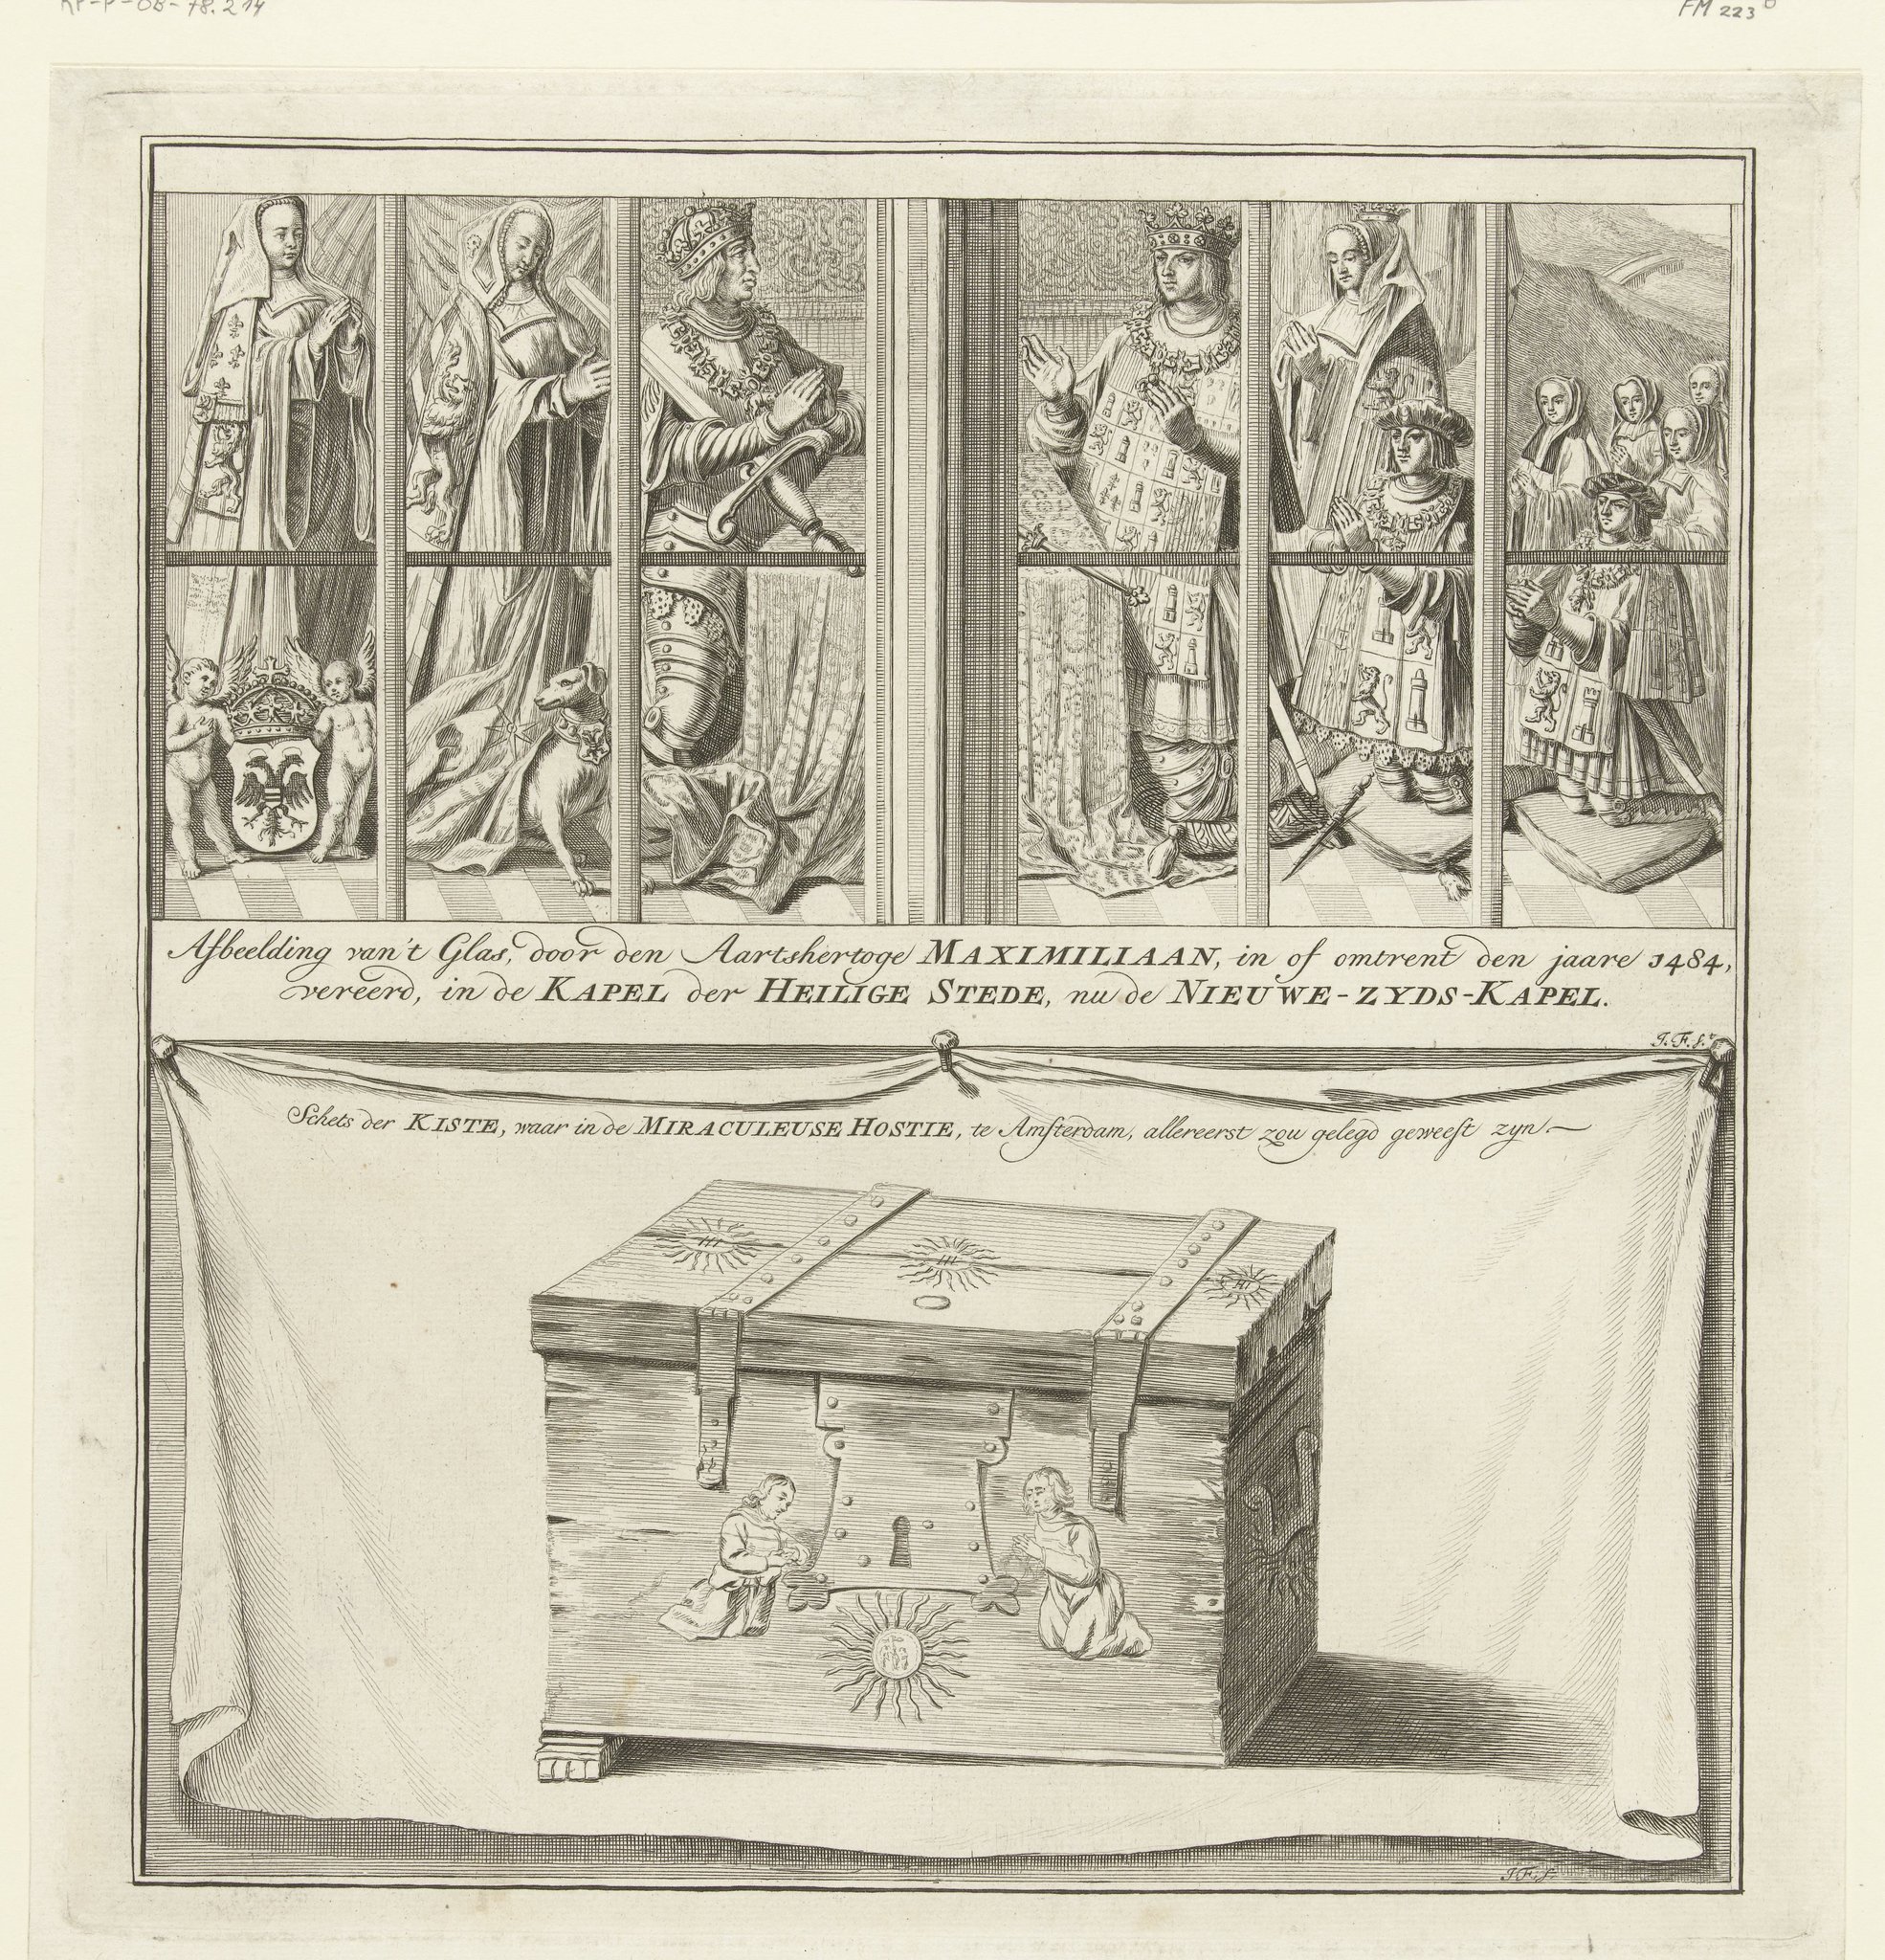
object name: print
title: Glasraam van keizer Maximiliaan I en Mirakelkist in de Heilige Stede te Amsterdam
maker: jacob folkema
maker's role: draughtsman, print maker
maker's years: 1692-1767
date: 1763-1765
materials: paper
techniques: etching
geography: northern netherlands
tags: maximilian i (holy roman emperor), church-window, e.g. rose-window, relics (and reliquaries), money-chest, treasure-chest, money-box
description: Illustratie voor: J. Wagenaar, Amsterdam, in zyne opkomst, aanwas, geschiedenissen, voorregten, koophandel, gebouwen, kerkenstaat, schoolen, schutterye, gilden en regeeringe, 4 delen, Isaak Tirion etc., Amsterdam 1760-1788, dl. II (1765), p. 122. Staat met de letter. De kist naar de tekening van Dilhof in het RPK.